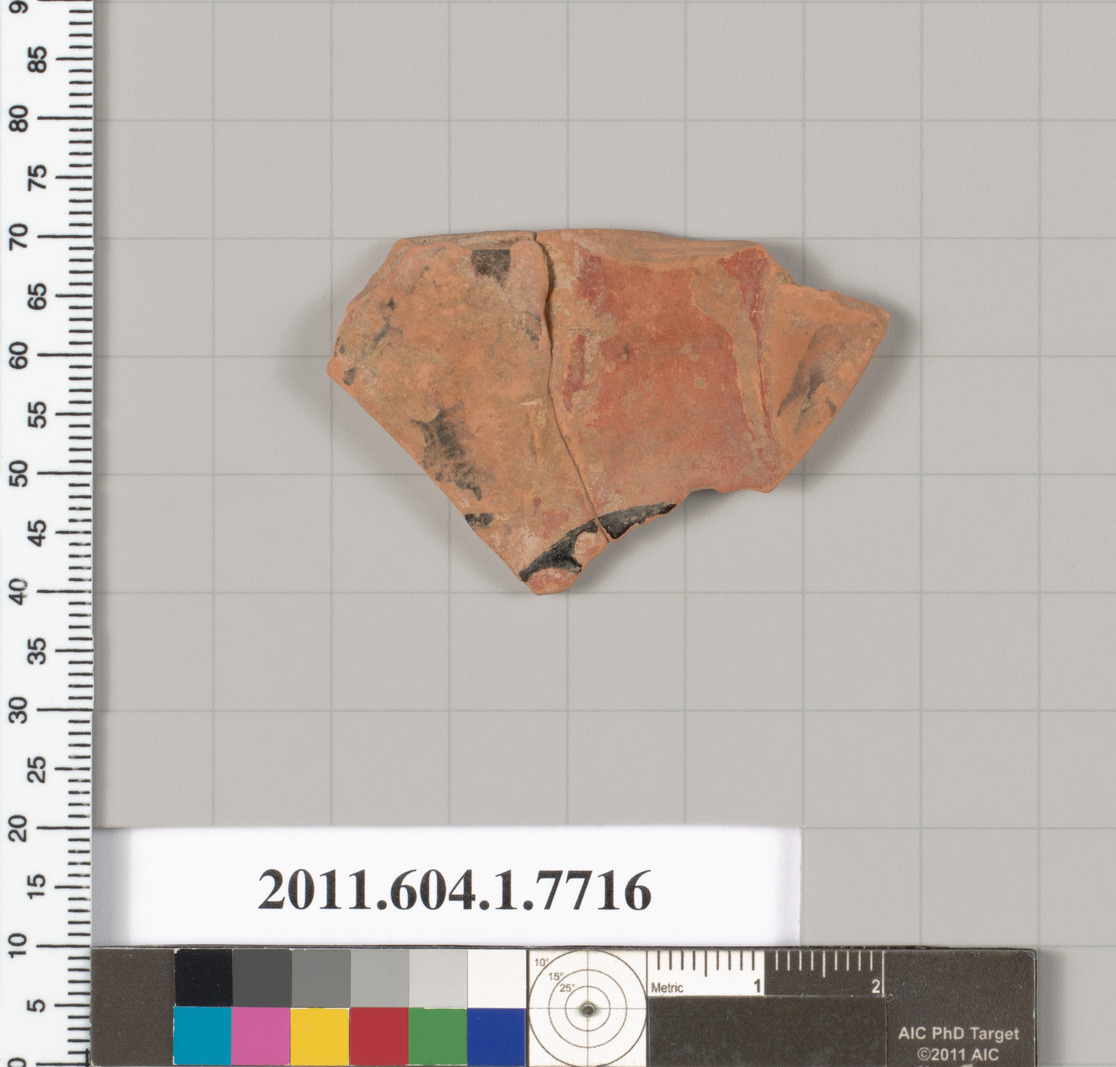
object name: kylix fragment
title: Terracotta fragment of a kylix (drinking cup)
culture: greek, attic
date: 460-450 BCE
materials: terracotta